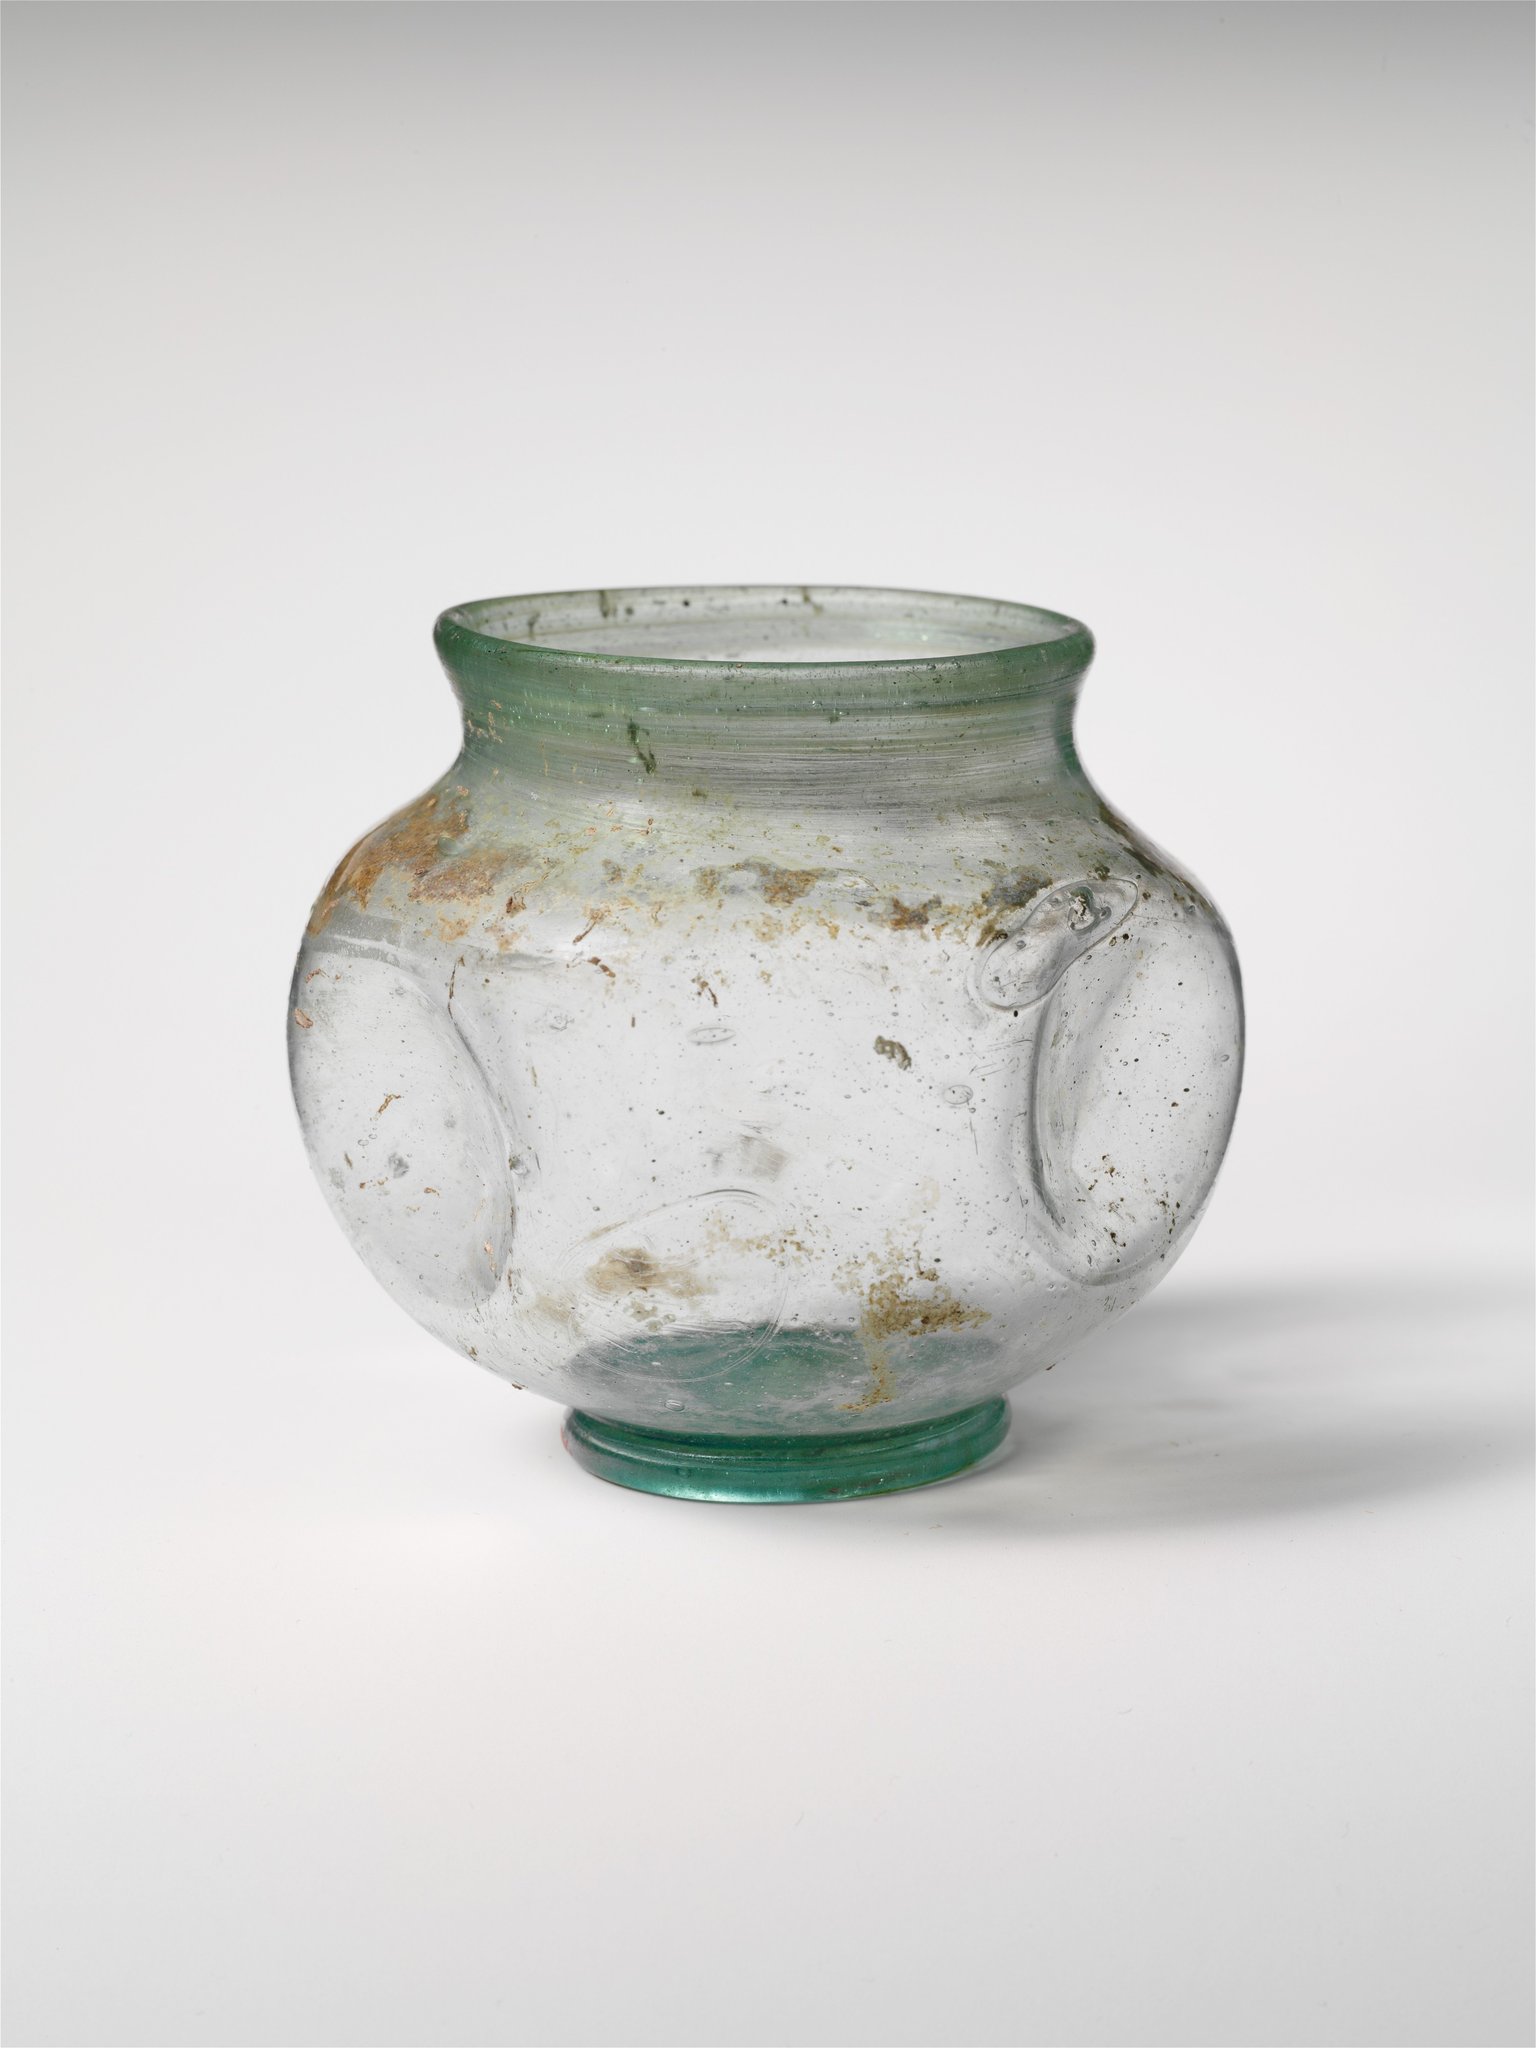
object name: jar, indented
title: Glass jar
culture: roman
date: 101-300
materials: glass